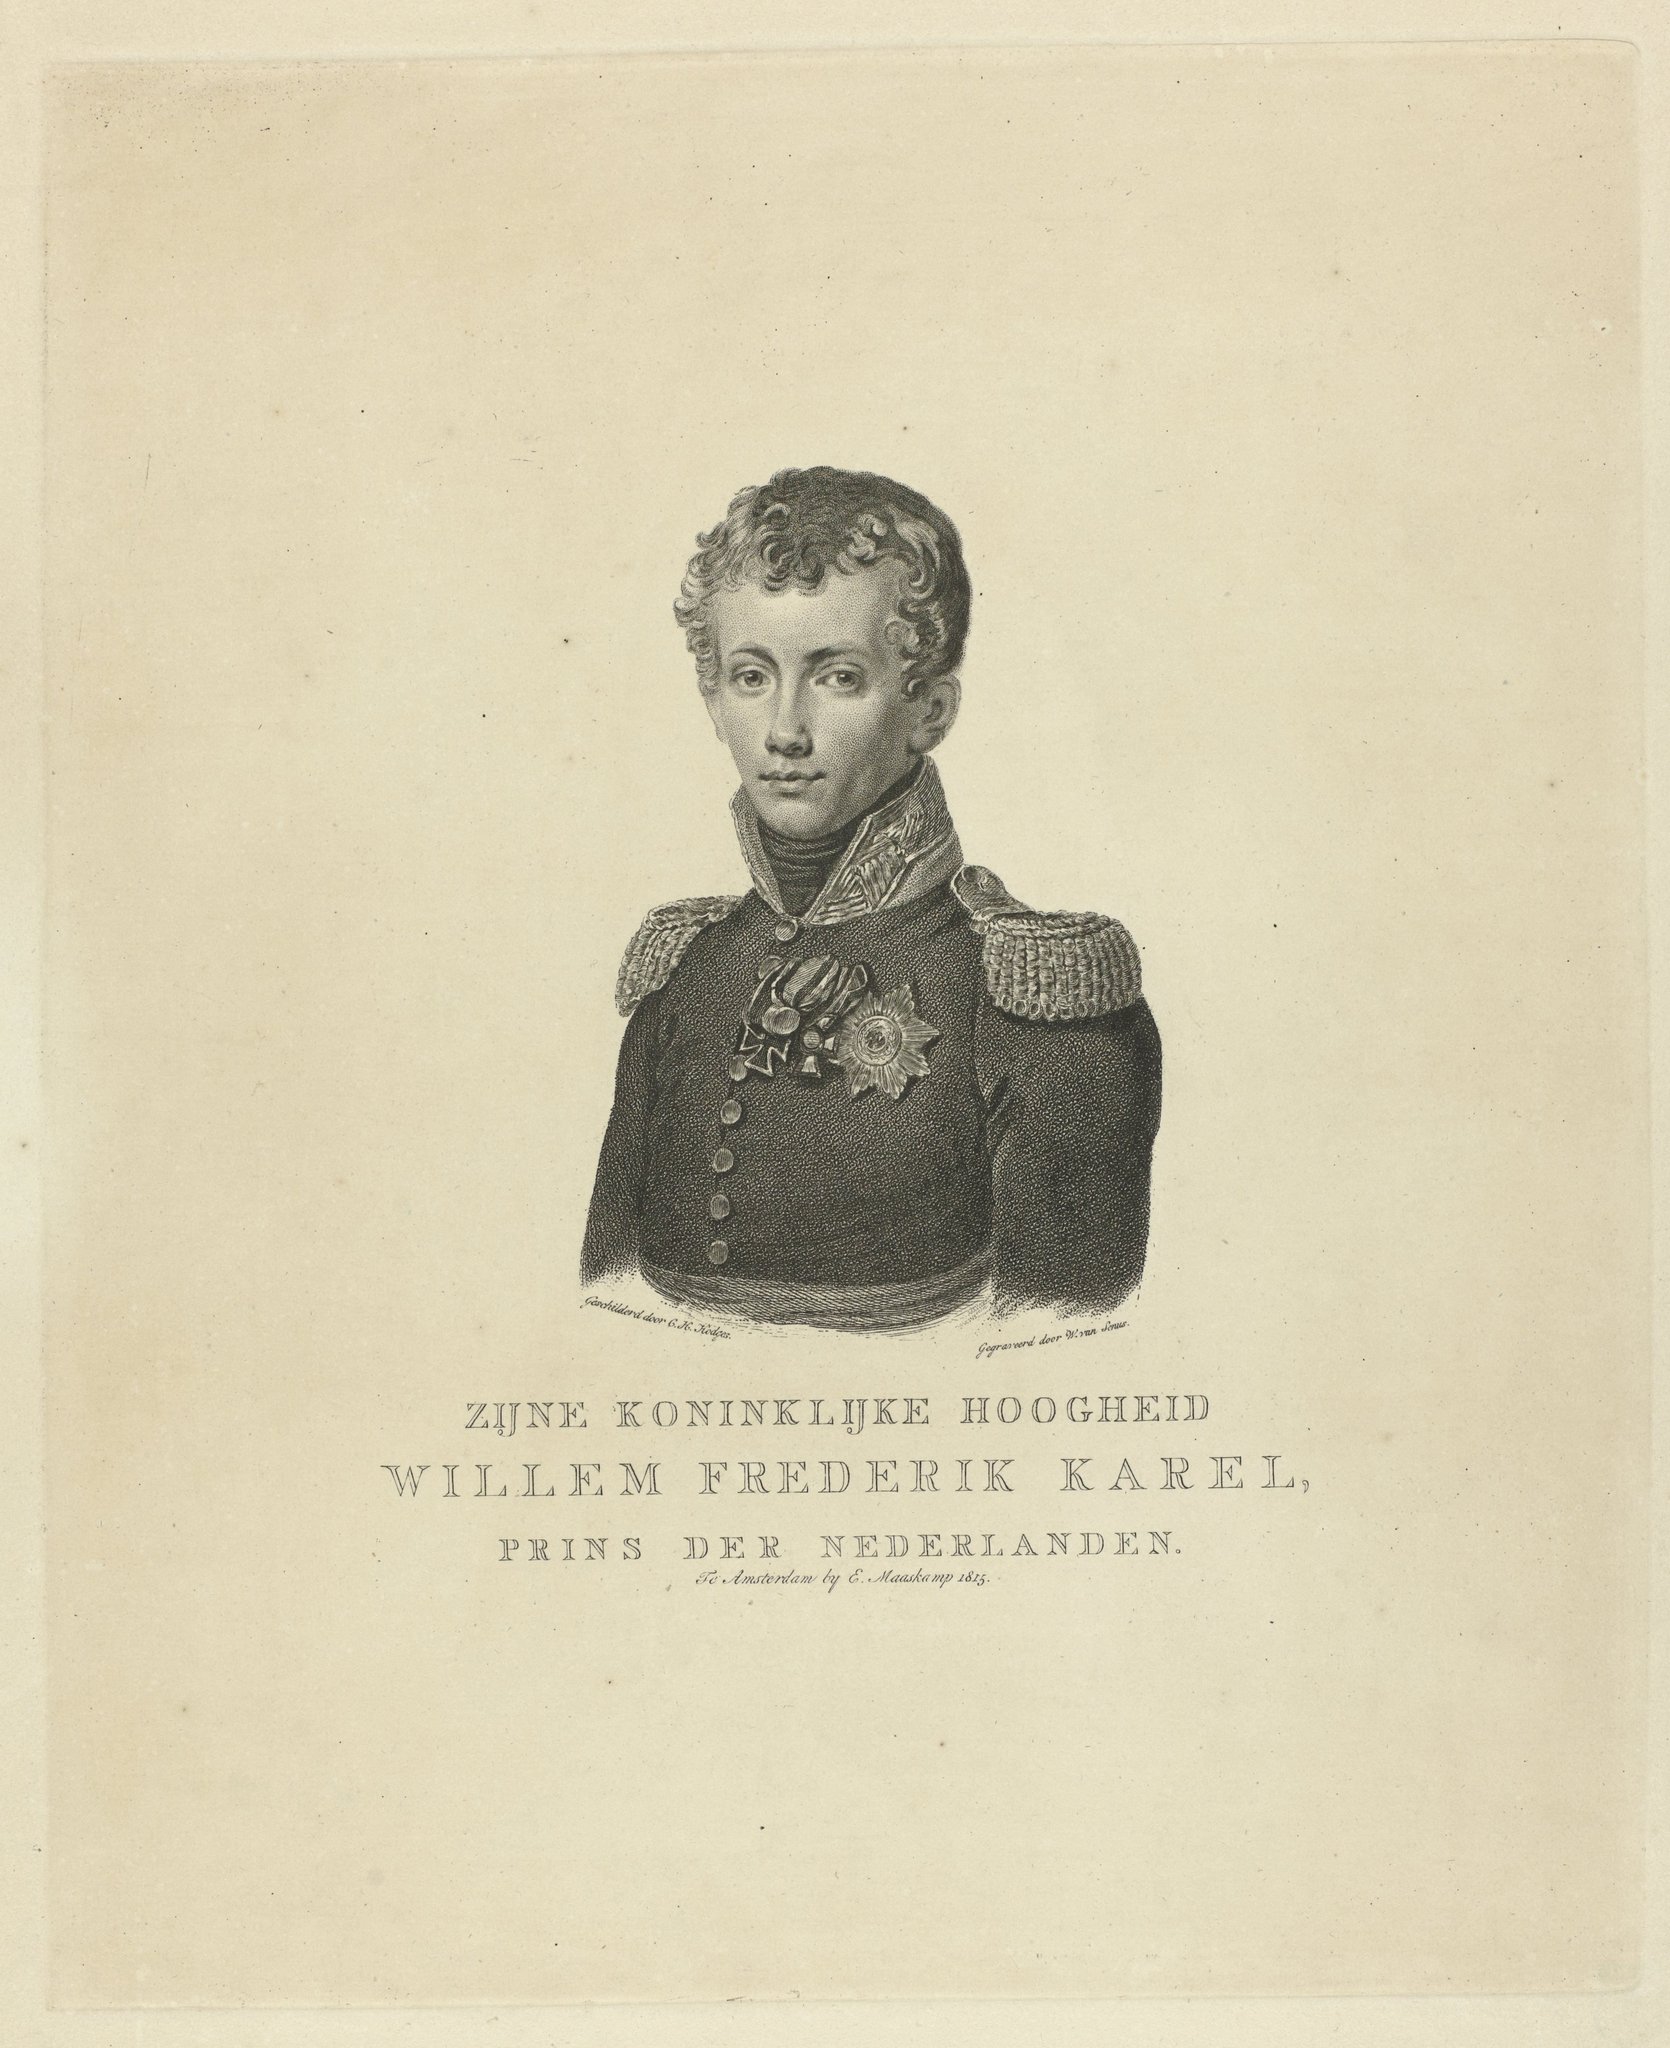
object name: print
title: Portret van Frederik, prins der Nederlanden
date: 1815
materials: paper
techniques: engraving, etching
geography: amsterdam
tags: berlin, frederik (prins der nederlanden), knighthood order (with name) - insignia of a knighthood order, e.g.: badge, chain (with name of order)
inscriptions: collector's mark: Lugt 963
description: De hier vermelde titel verwijst naar de hoogst verkregen titel van de geportretteerde, niet per se naar de titel die de geportretteerde op deze voorstelling draagt.